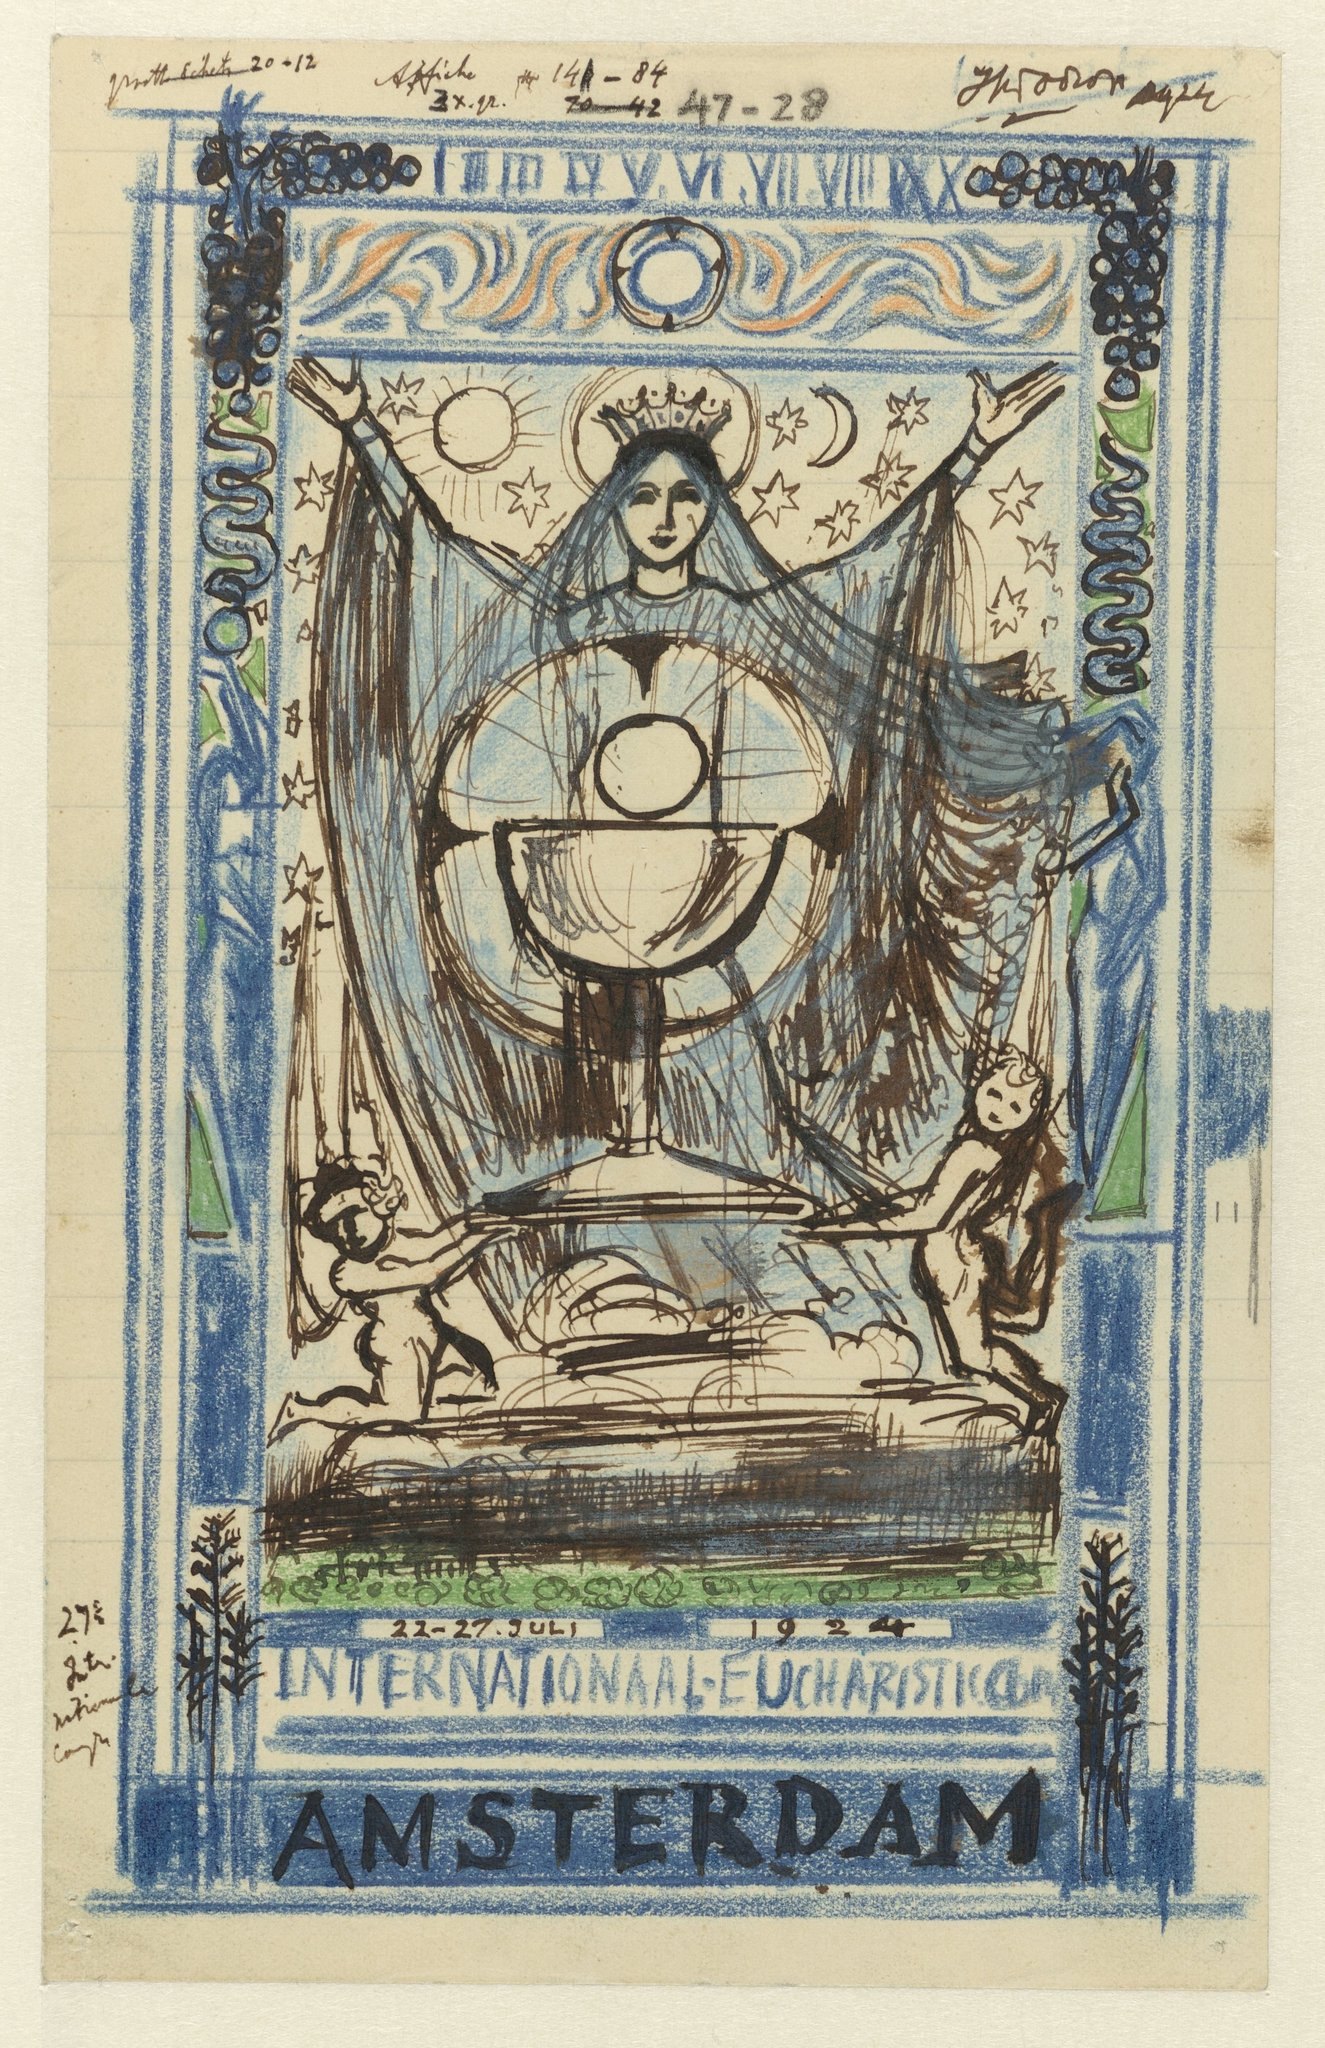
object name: drawing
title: Ontwerp voor een affiche voor het Internationale Eucharistisch Congres gehouden te Amsterdam van 22-27 juli 1924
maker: jan toorop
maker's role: draughtsman, painter, print maker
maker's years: 1858-1928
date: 1868-1928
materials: chalk, ink, paper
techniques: pen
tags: poster, international eucharistic congress